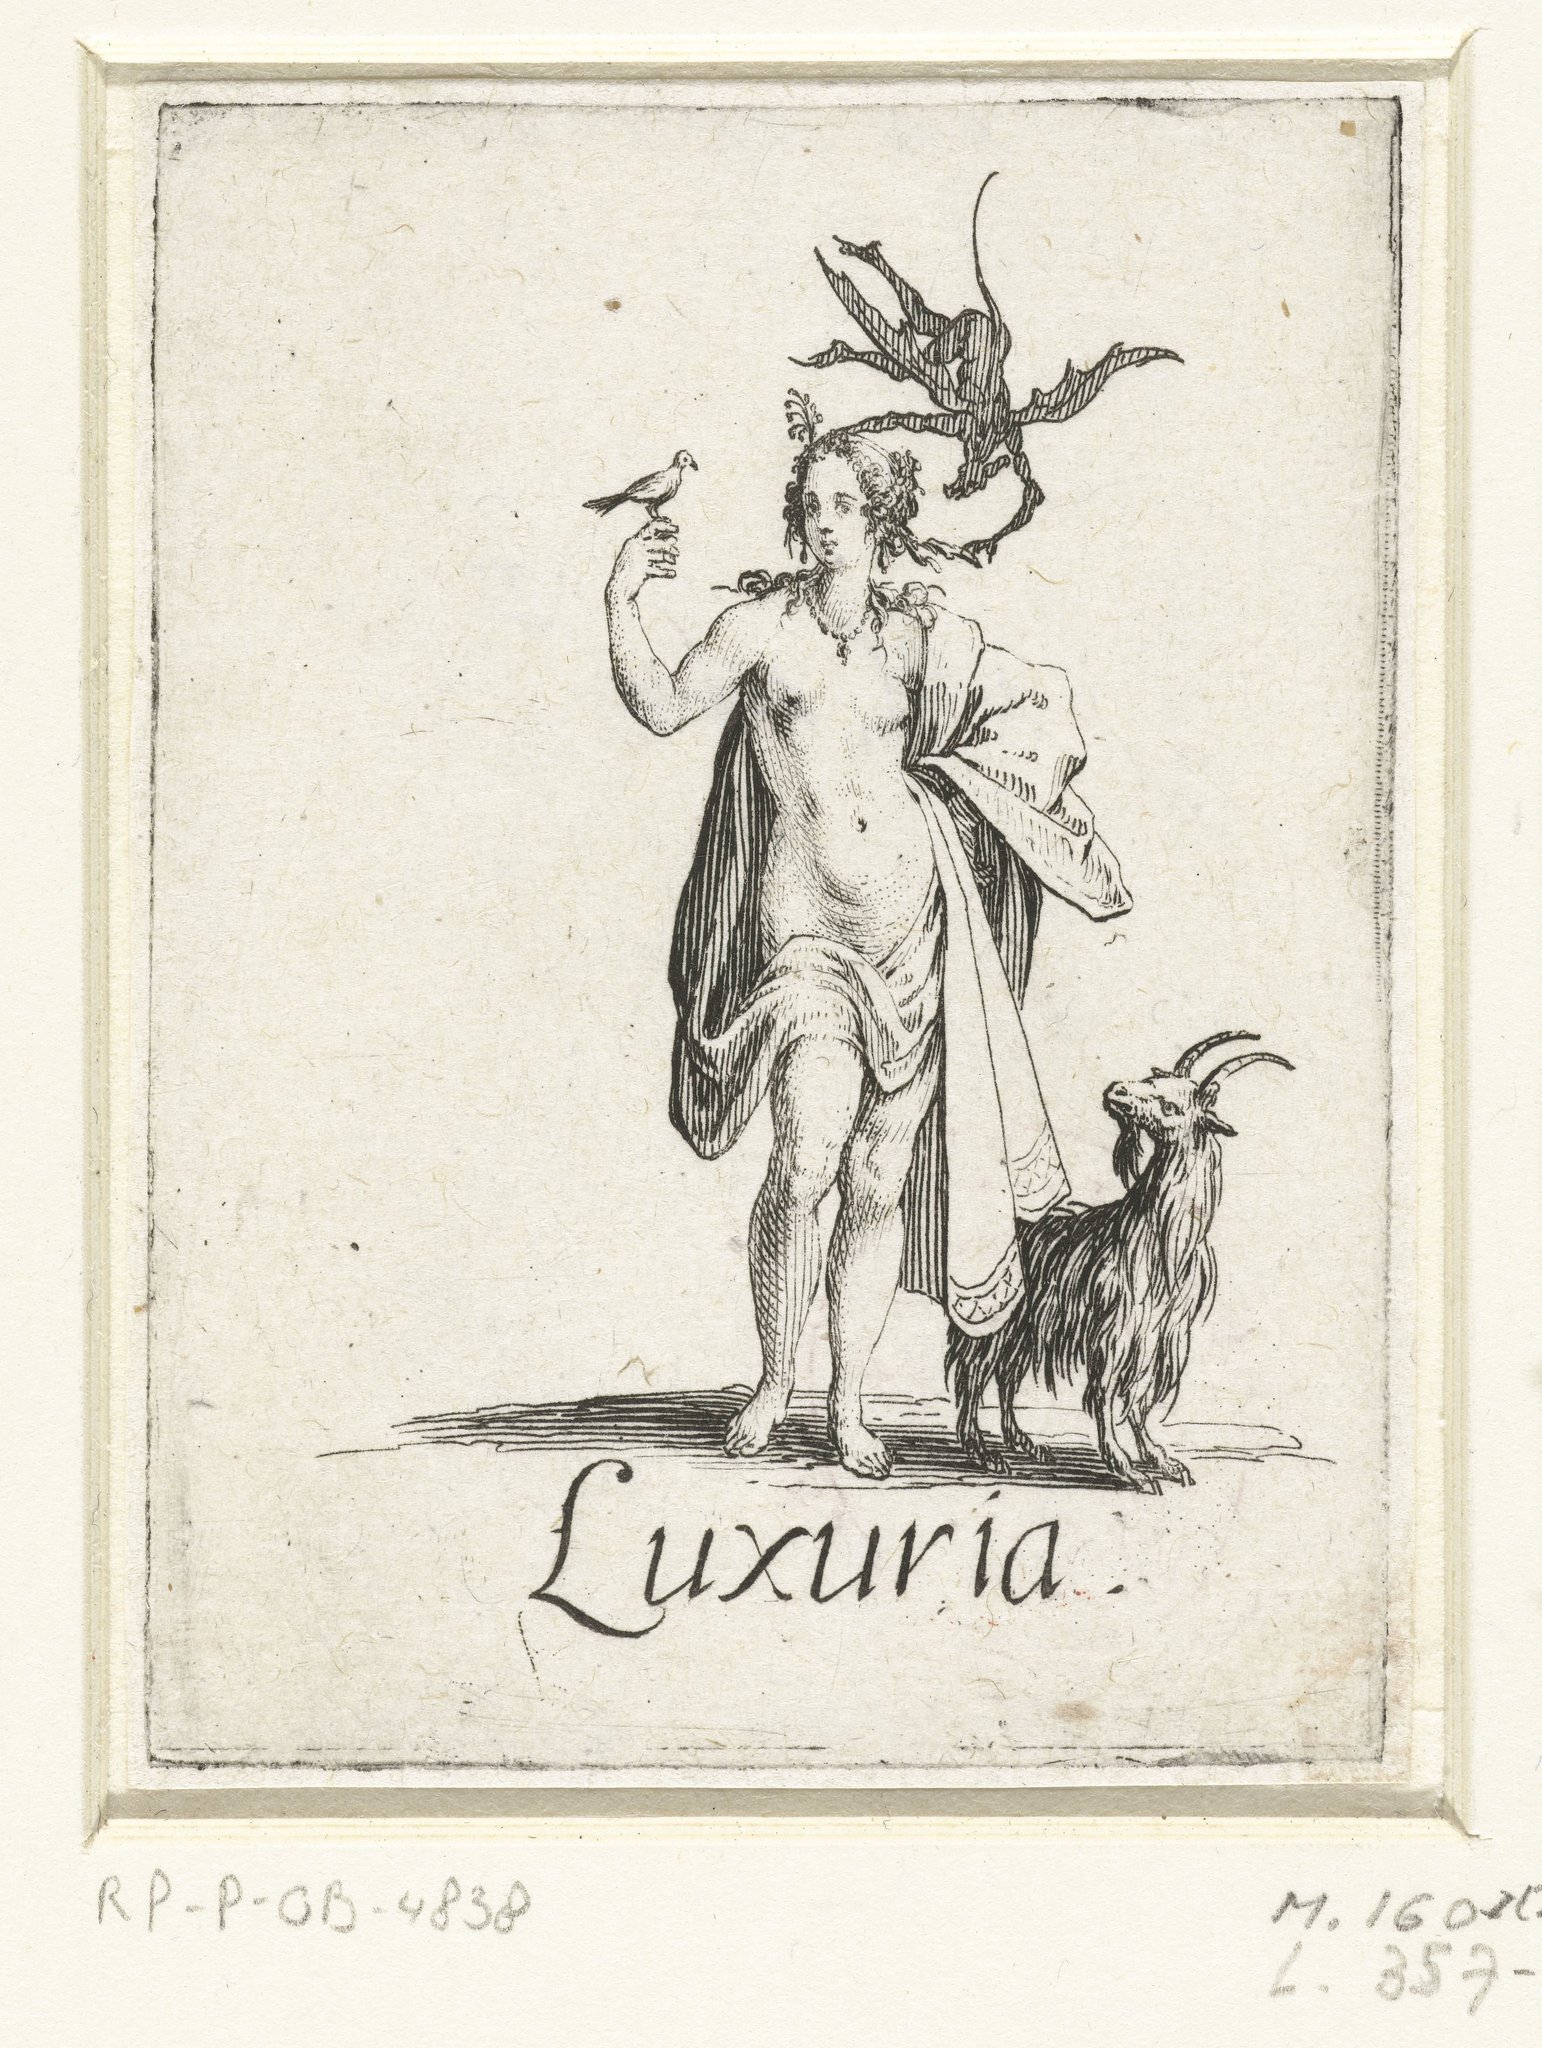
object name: print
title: Luxuria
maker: jacques callot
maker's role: draughtsman, print maker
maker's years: 1592-1635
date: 1618-1625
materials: paper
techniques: etching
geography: florence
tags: lust, luxury, 'luxuria'; 'lussuria' (ripa) ~ personification of one of the deadly sins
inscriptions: collector's mark: Lugt 240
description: Een schaarsgeklede dame laat een vogeltje op haar hand zitten. Naast haar staat een geit, boven haar vliegt een duiveltje. Onder de voorstelling de Latijnse term voor de zonde die de vrouw verbeeldt. Deze prent is onderdeel van een serie van zeven prenten waarop de hoofdzonden als allegorische figuren zijn weergegeven.